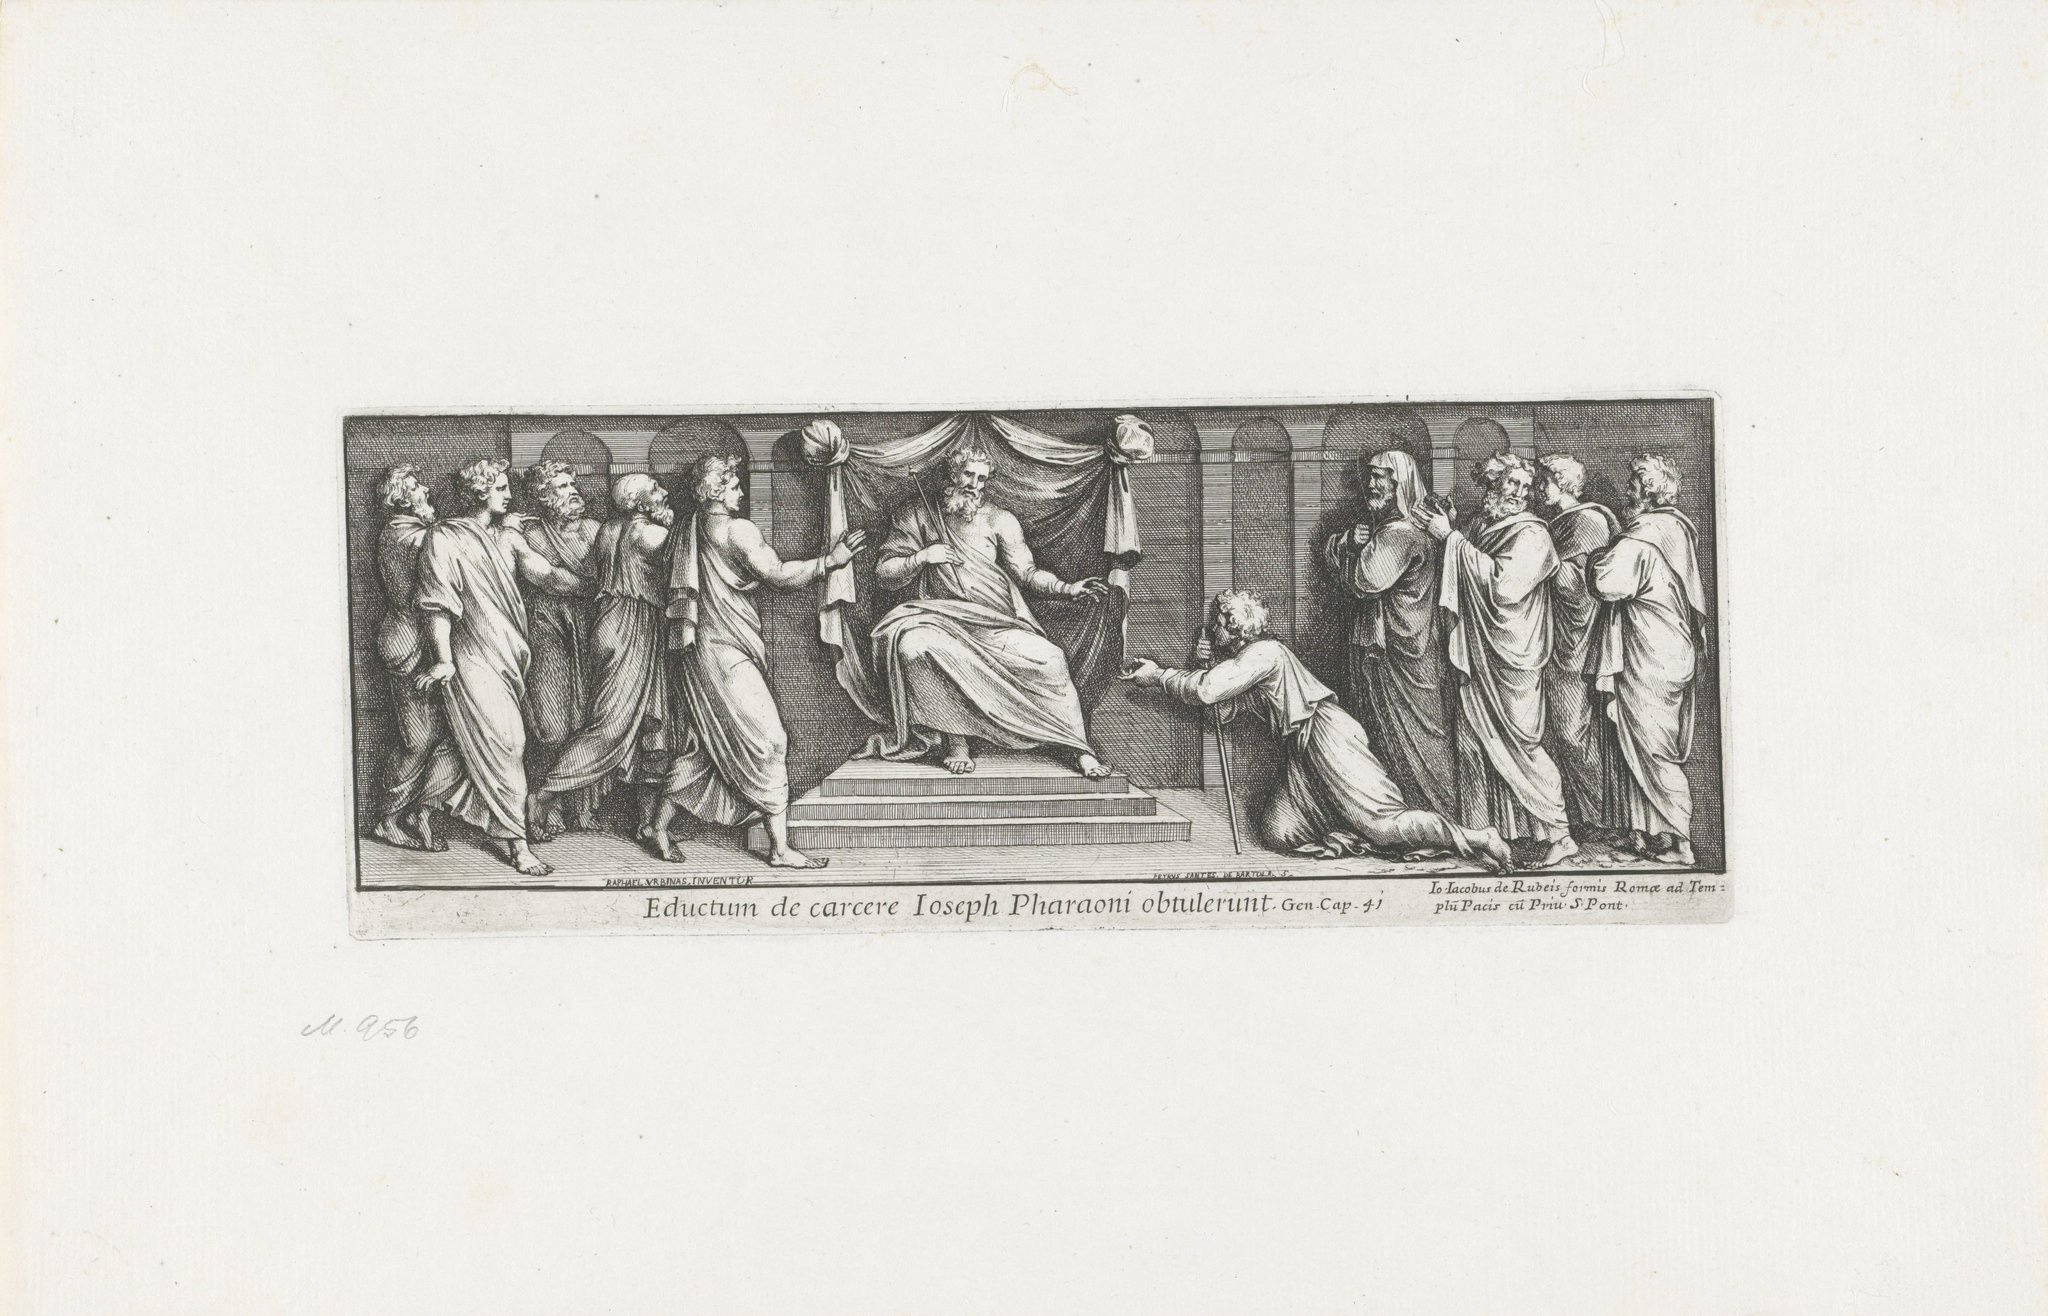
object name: print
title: Eductuum de carcere Ioseph Pharaoni obtulerunt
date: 1645-1700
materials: paper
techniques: engraving, etching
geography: vatican city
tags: story of joseph (part i)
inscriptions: collector's mark: Lugt 2228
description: Prent uit een reeks van 14 prenten (+ titelprent) naar schilderingen door Rafaël in de Stanze di Raffaello in het Apostolisch Paleis in het Vaticaan en naar ontwerpen voor wandtapijten voor de Sixtijnse Kapel door Rafaël. Naar een schildering door Rafaël in de Stanza di Eliodoro.